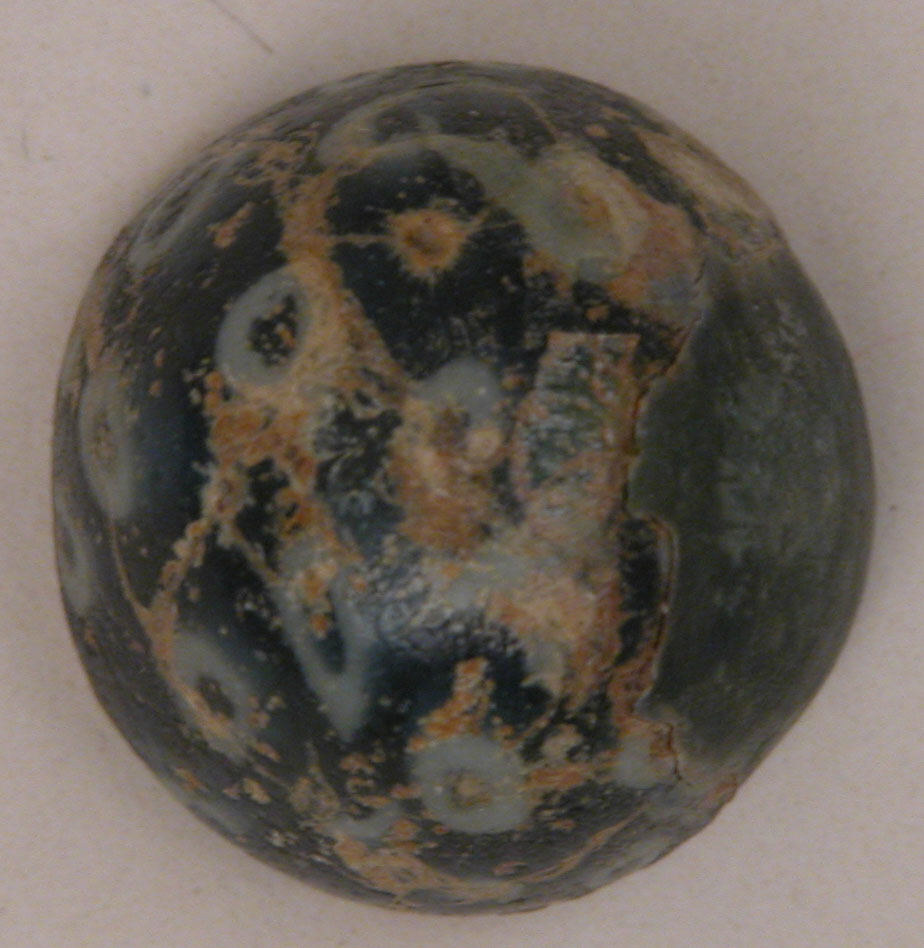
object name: gaming piece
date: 701-1200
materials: glass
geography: islamic lands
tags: games